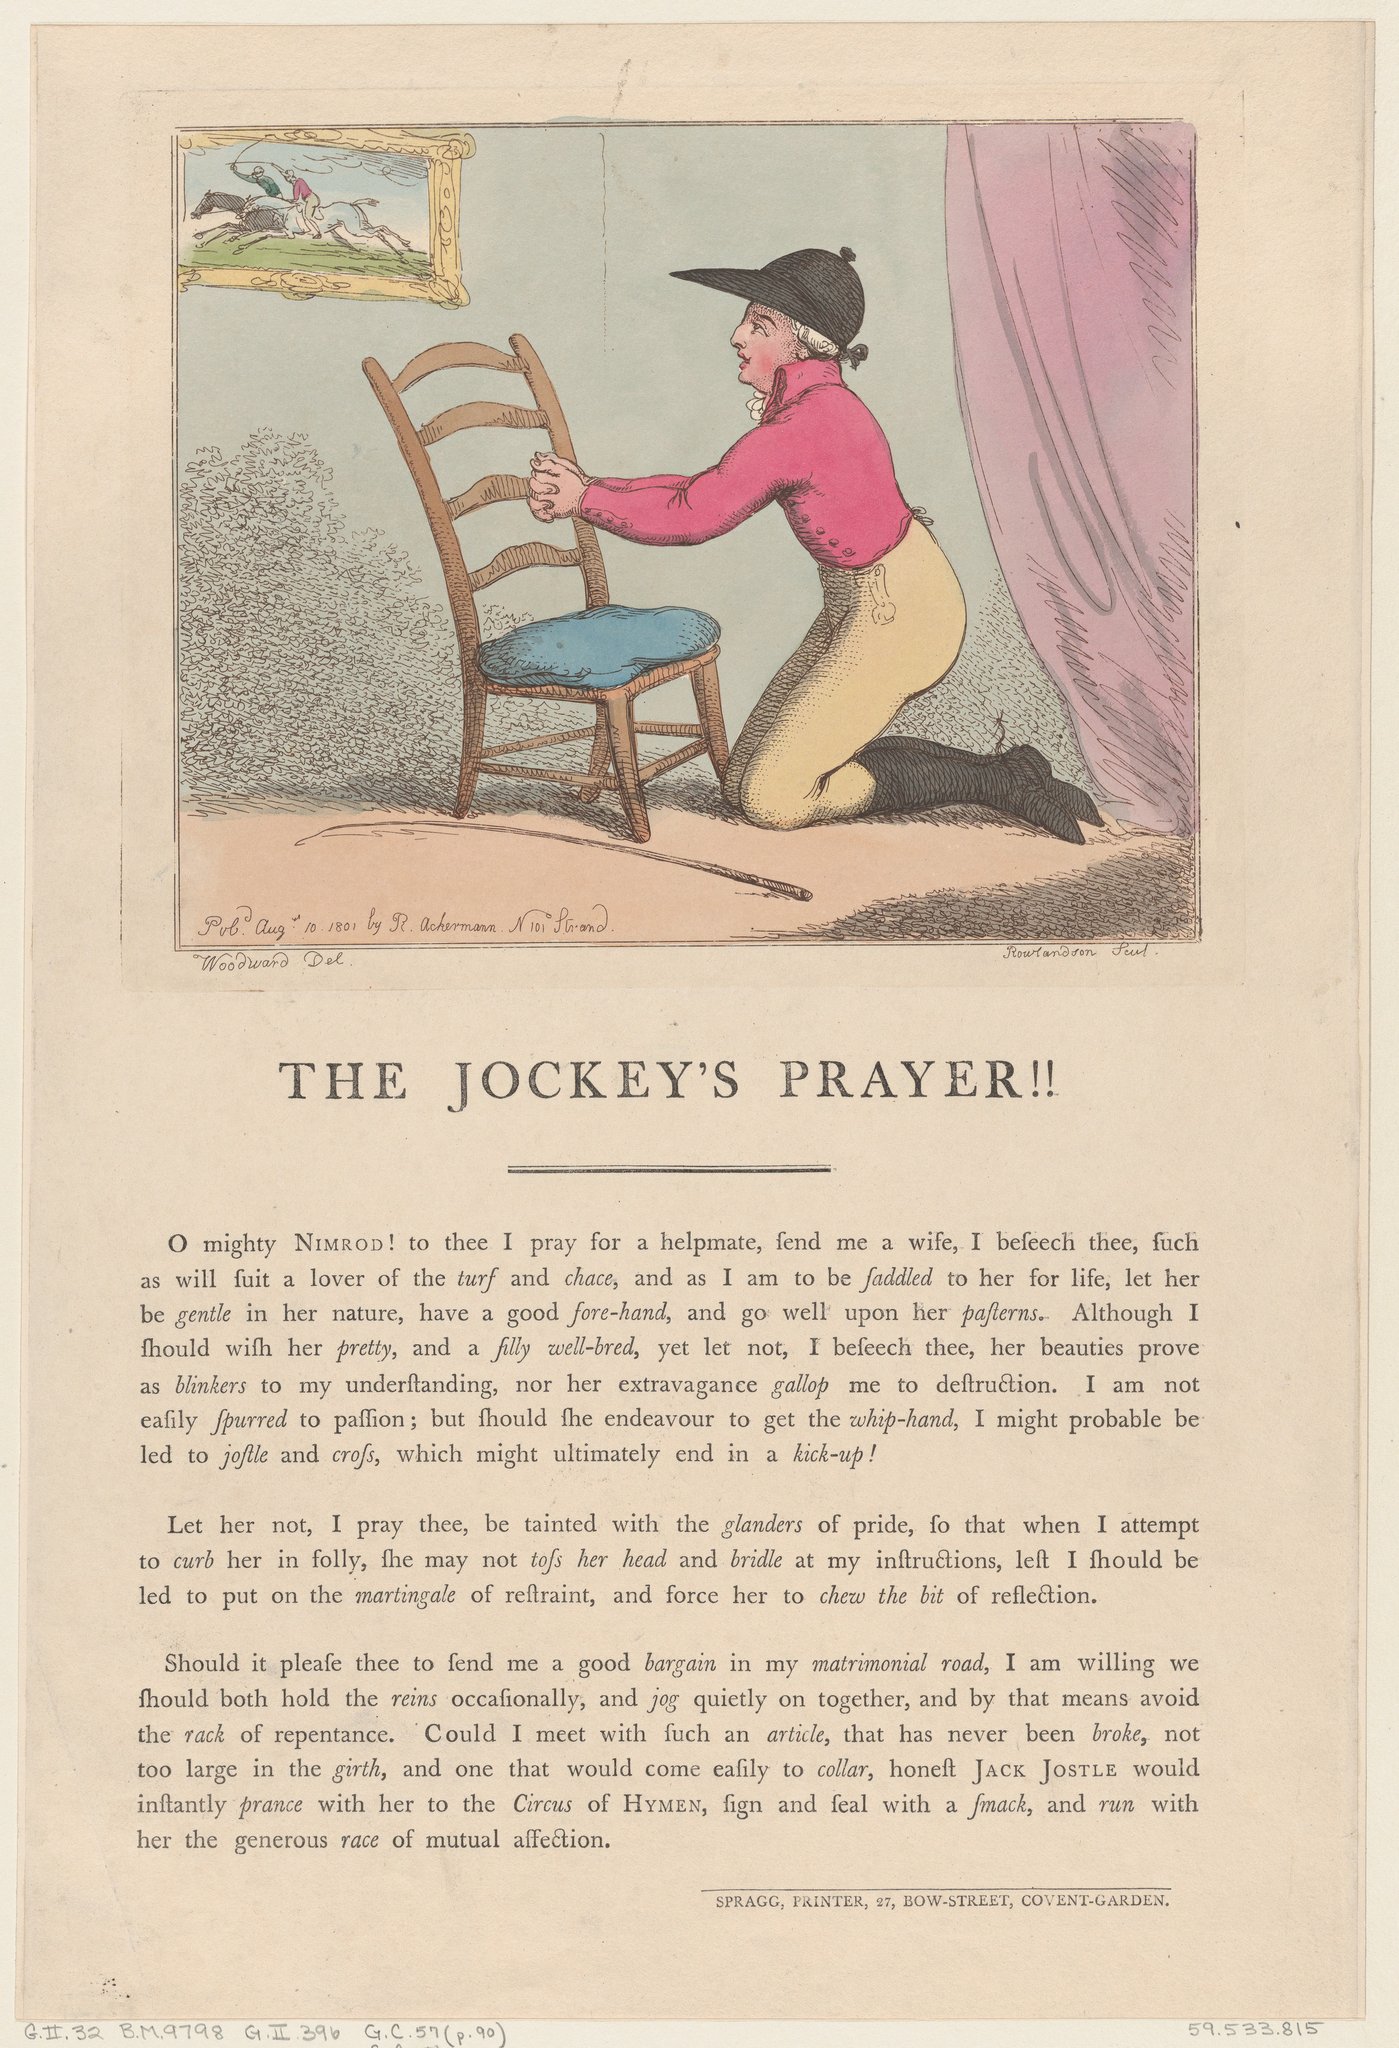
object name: print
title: The Jockey's Prayer!!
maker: thomas rowlandson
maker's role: artist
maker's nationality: british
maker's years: 1757-1827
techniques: etching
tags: jockeys